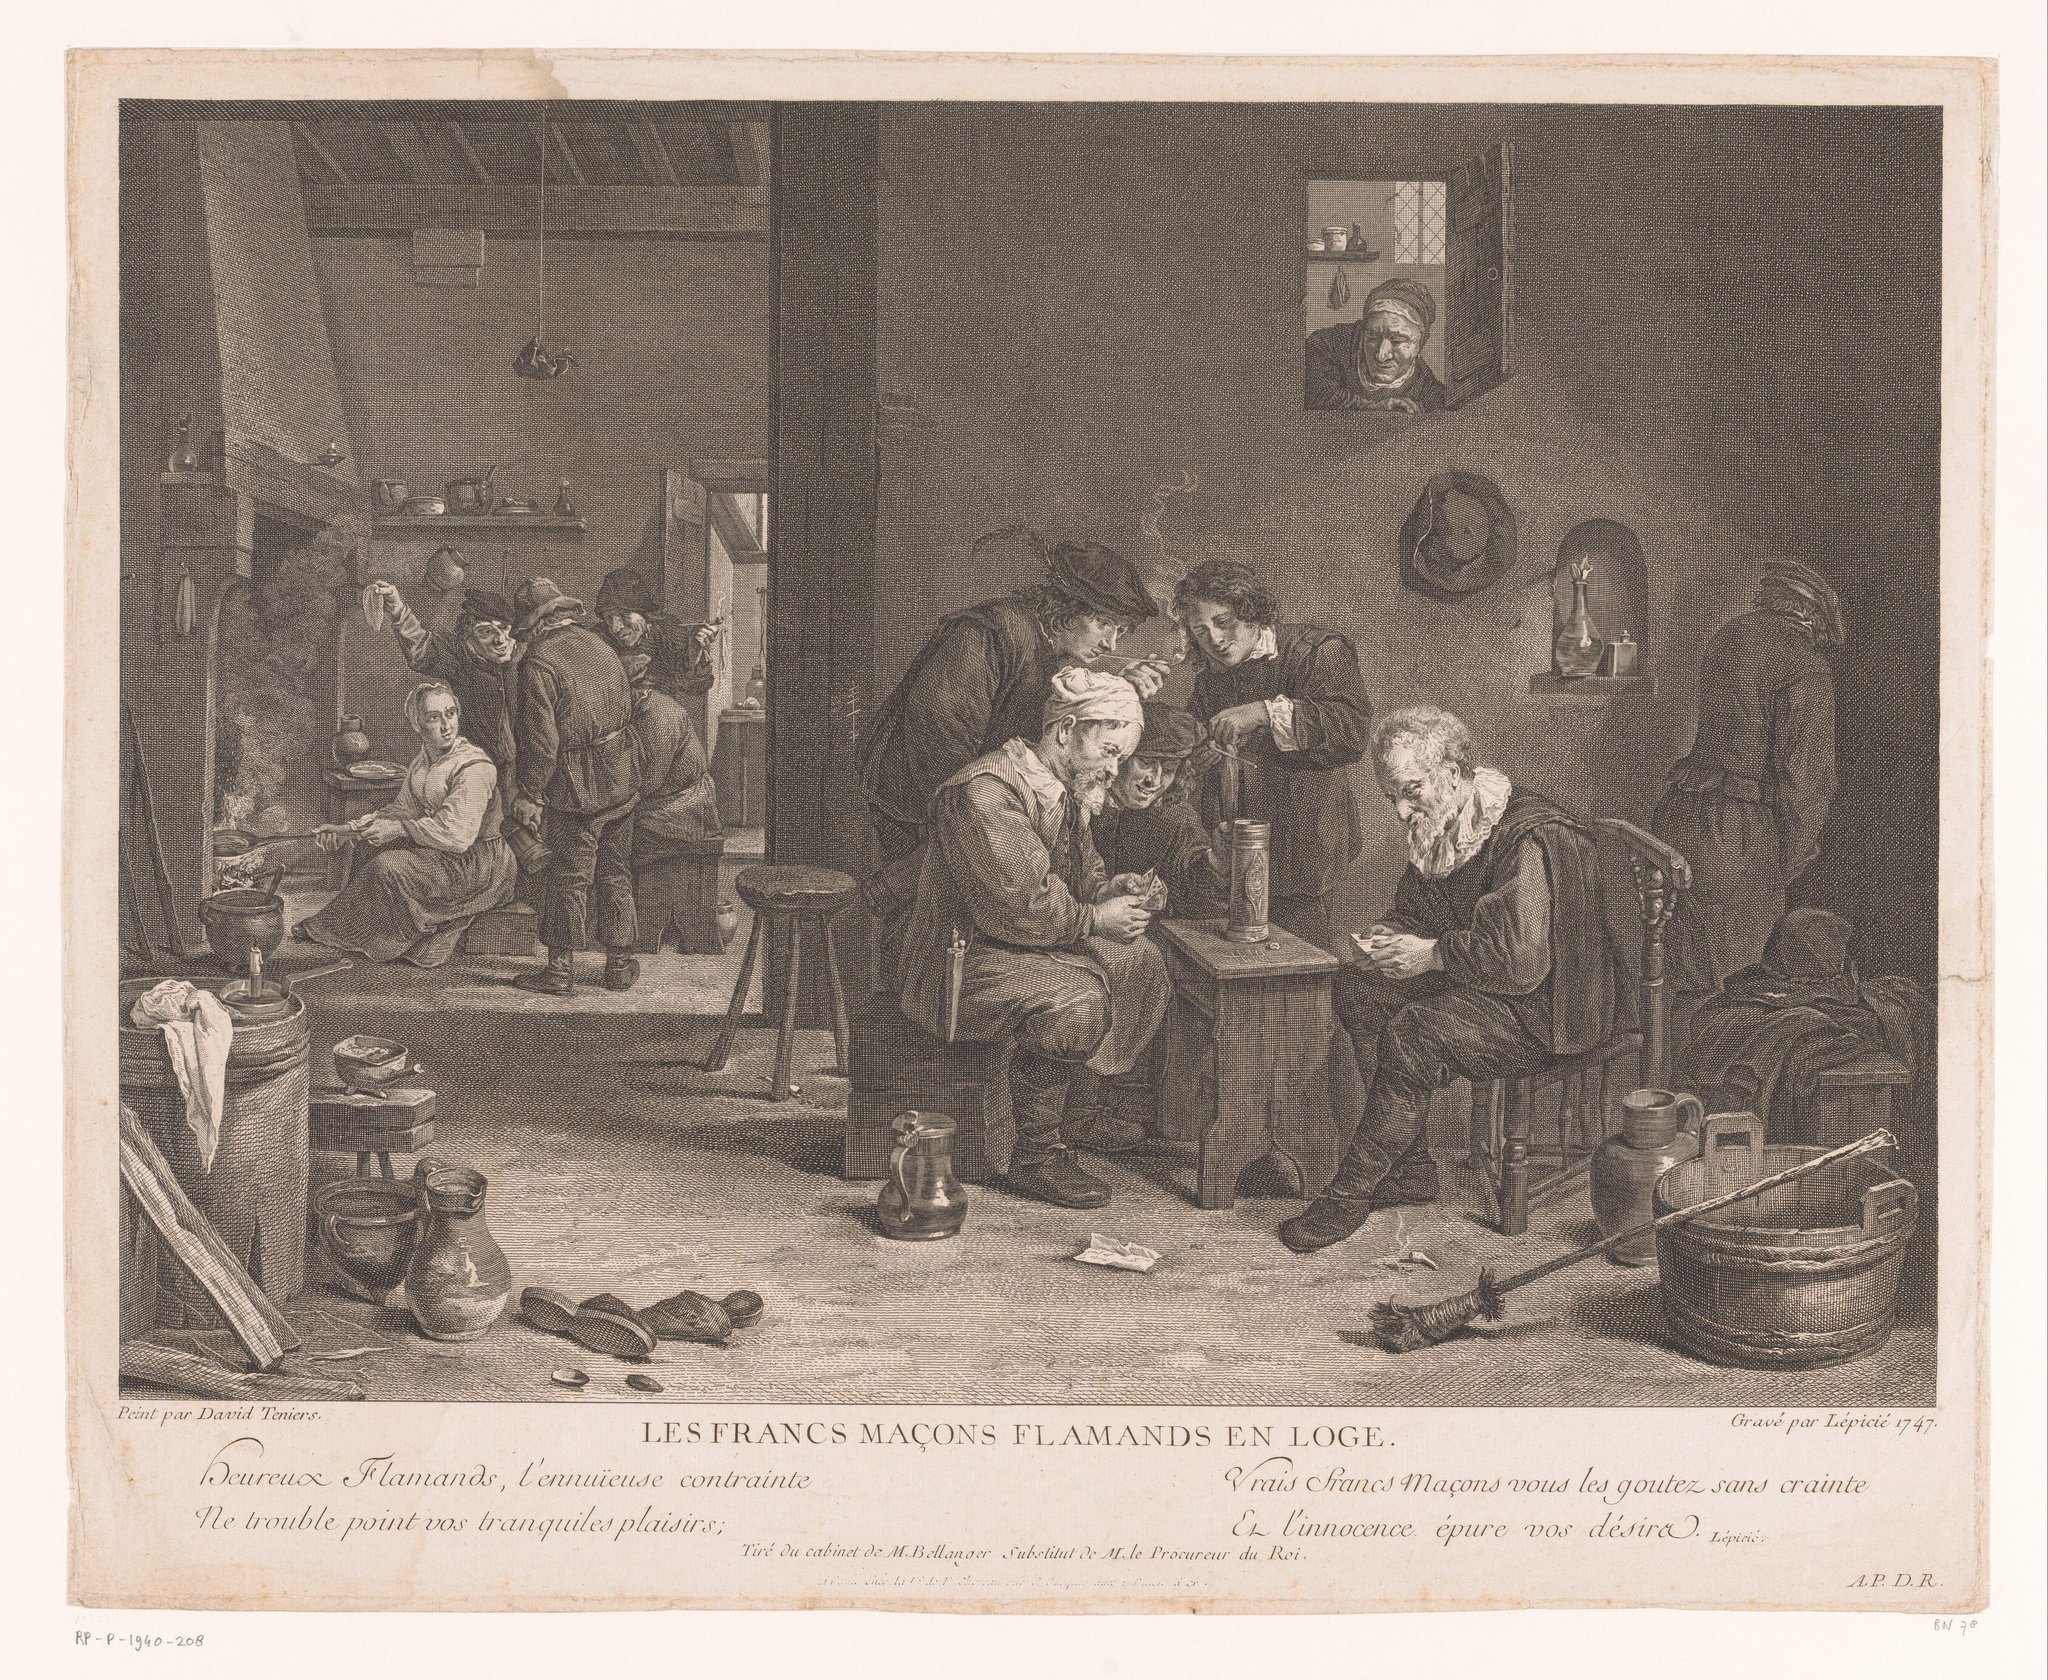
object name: print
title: Les Francs Maçons Flamands en Loge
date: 1729-1768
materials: paper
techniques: engraving, etching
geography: france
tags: inn, coffee-house, public house, etc., playing-cards, hotel, hostelry, inn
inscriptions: collector's mark: Lugt 2228